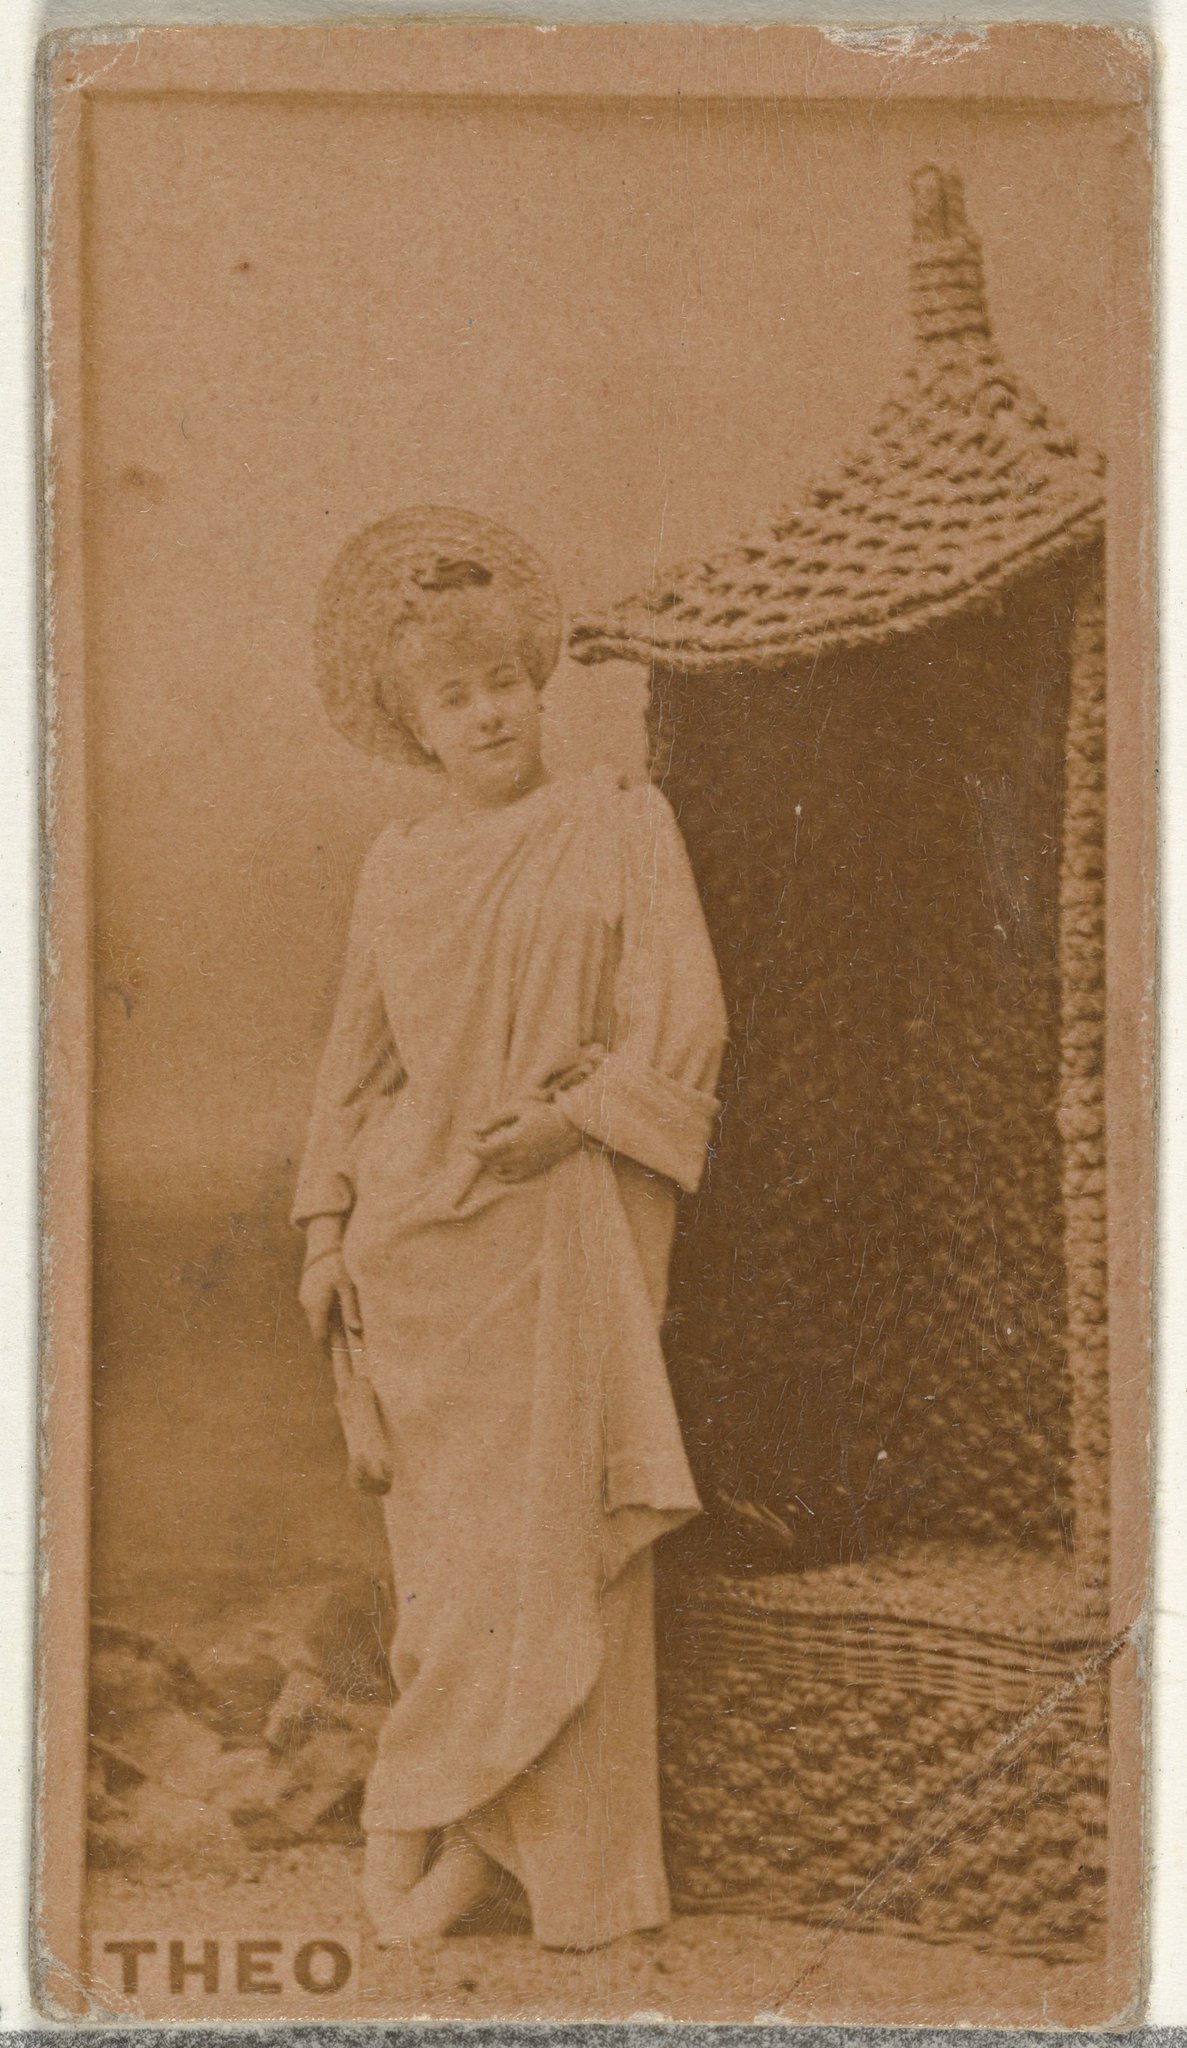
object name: photograph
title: Theo, from the Actors and Actresses series (N145-8) issued by Duke Sons & Co. to promote Duke Cigarettes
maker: w. duke, sons & co.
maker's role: publisher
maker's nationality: american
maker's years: 1870-1920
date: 1891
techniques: albumen silver print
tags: portraits,women,actresses